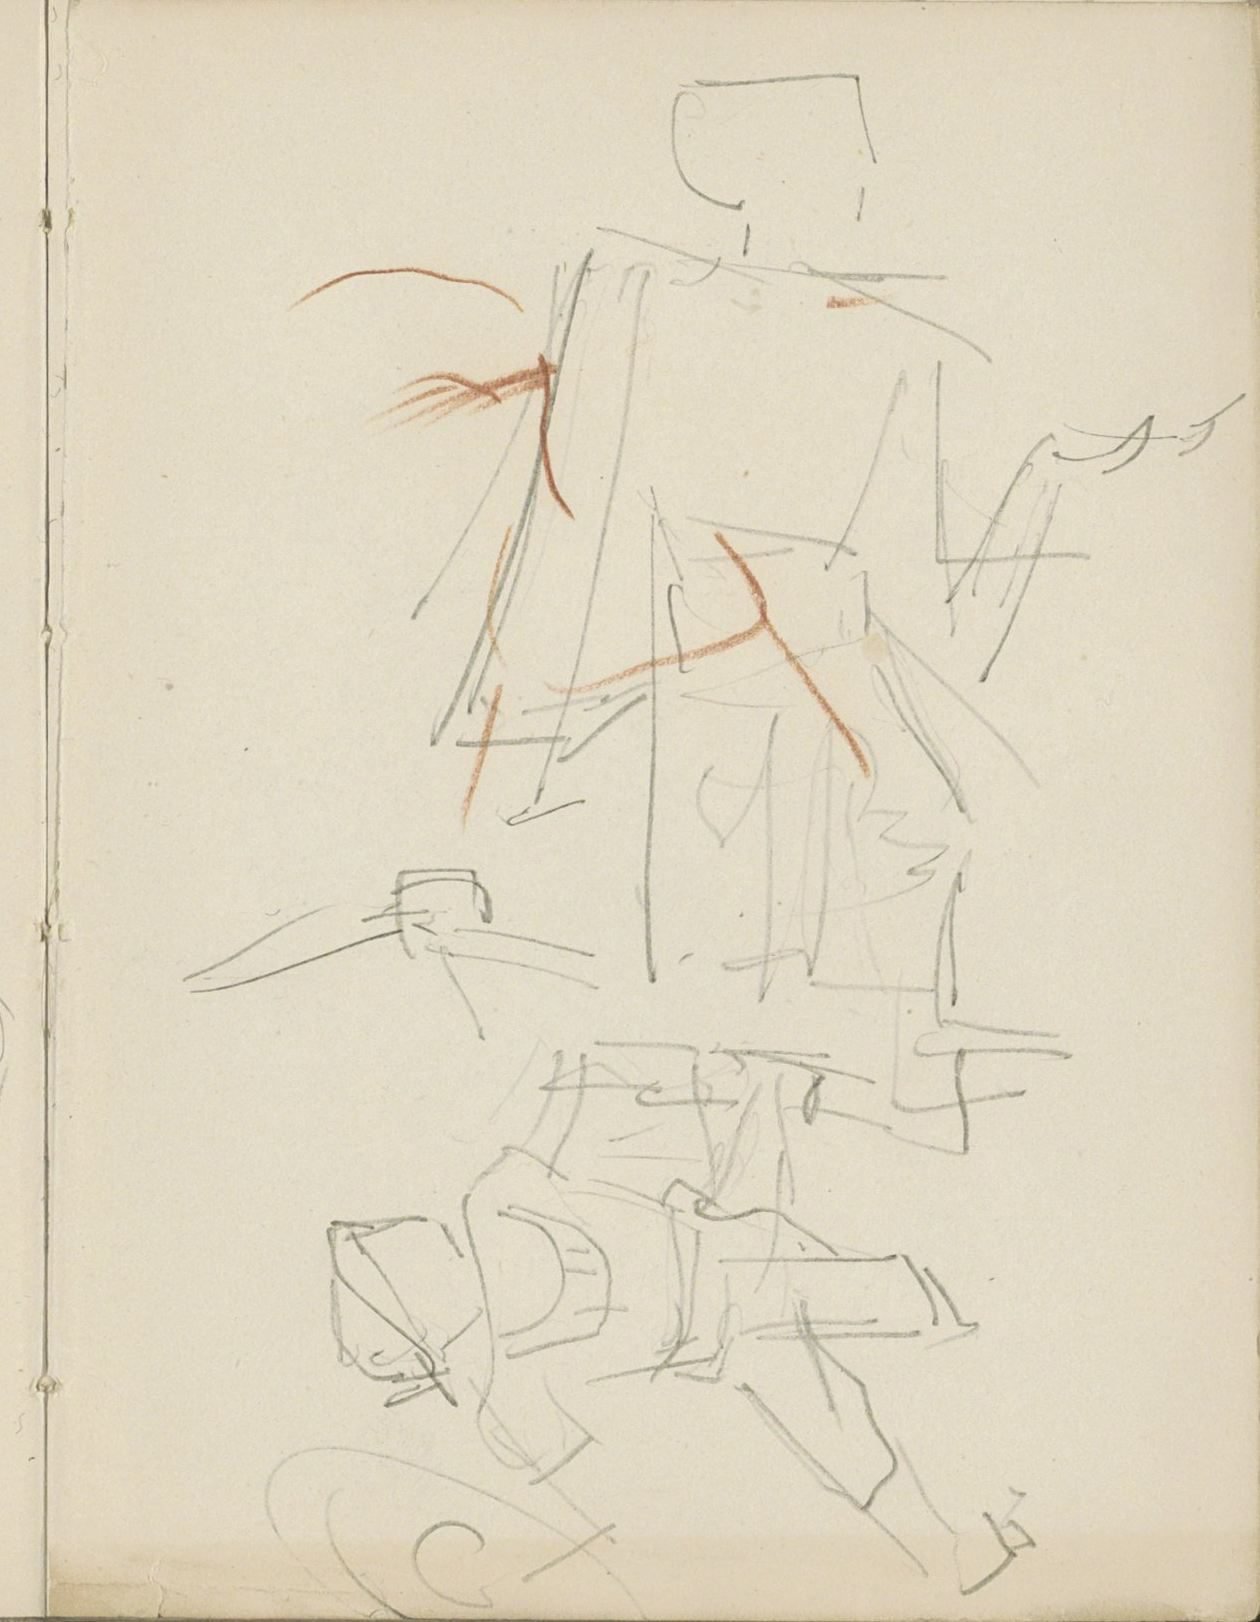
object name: sketchbook leaf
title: Dansers in traditioneel kostuum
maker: reijer stolk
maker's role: draughtsman, print maker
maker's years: 1896-1945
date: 1906-1945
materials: paper, pencil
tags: folk costume, regional costume, man dancing alone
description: Eén van de dansers draagt een mes. Mogelijk Javaanse dansers. Blad 4 recto uit een schetsboek met 69 bladen.